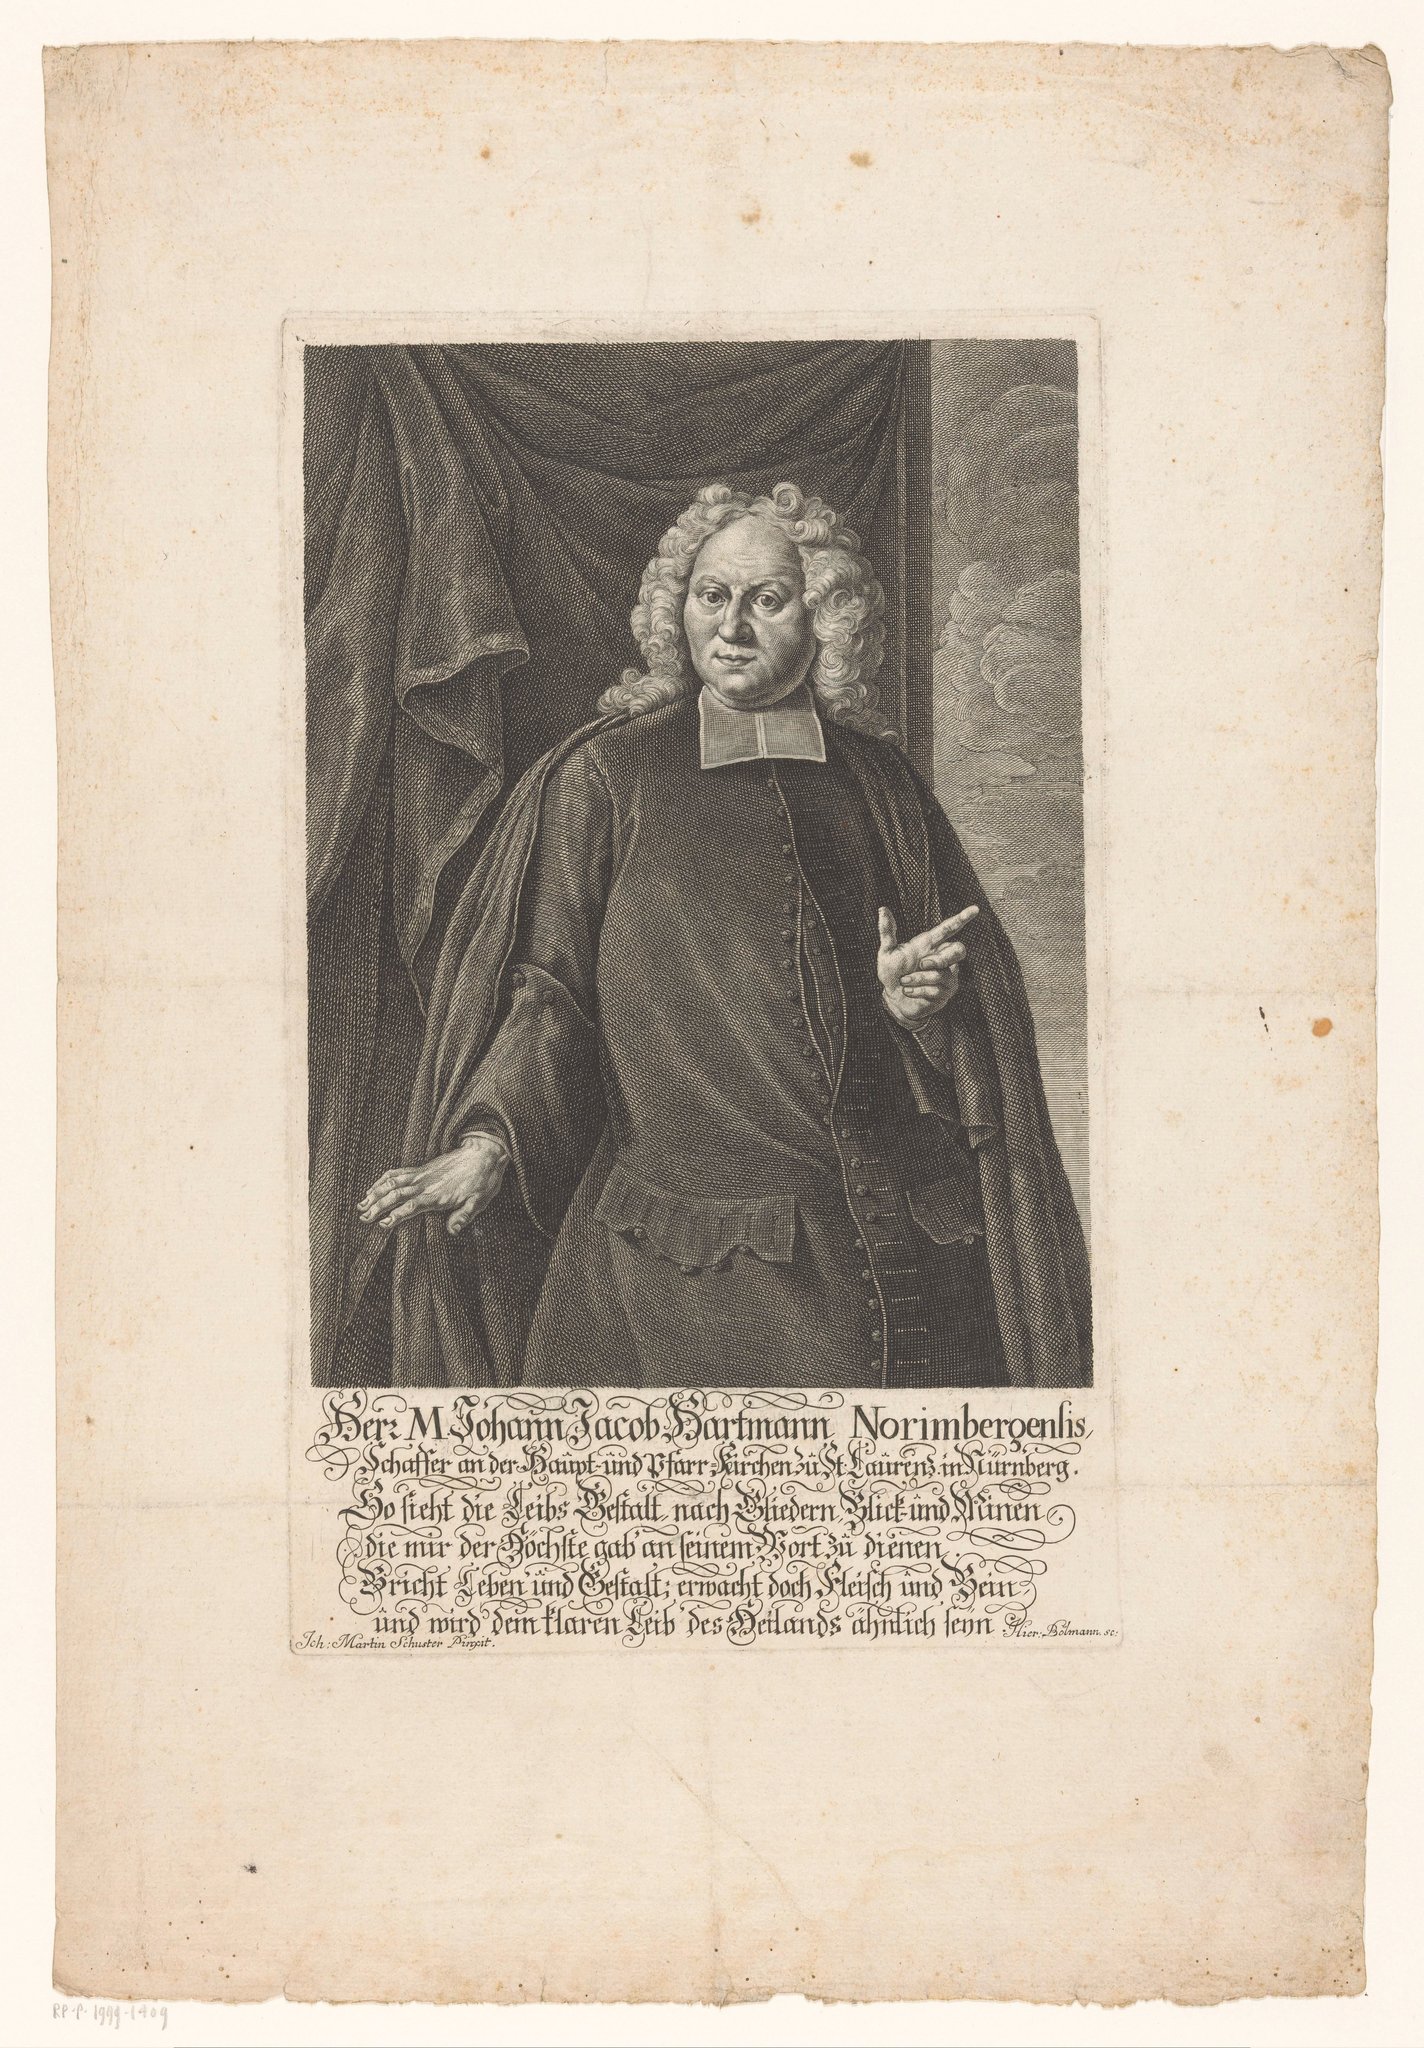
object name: print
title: Portret van Johann Jacob Hartmann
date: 1710-1730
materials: paper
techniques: engraving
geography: nuremberg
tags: johann jacob hartmann, historical persons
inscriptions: collector's mark: Lugt 2760, collector's mark: Lugt 2228